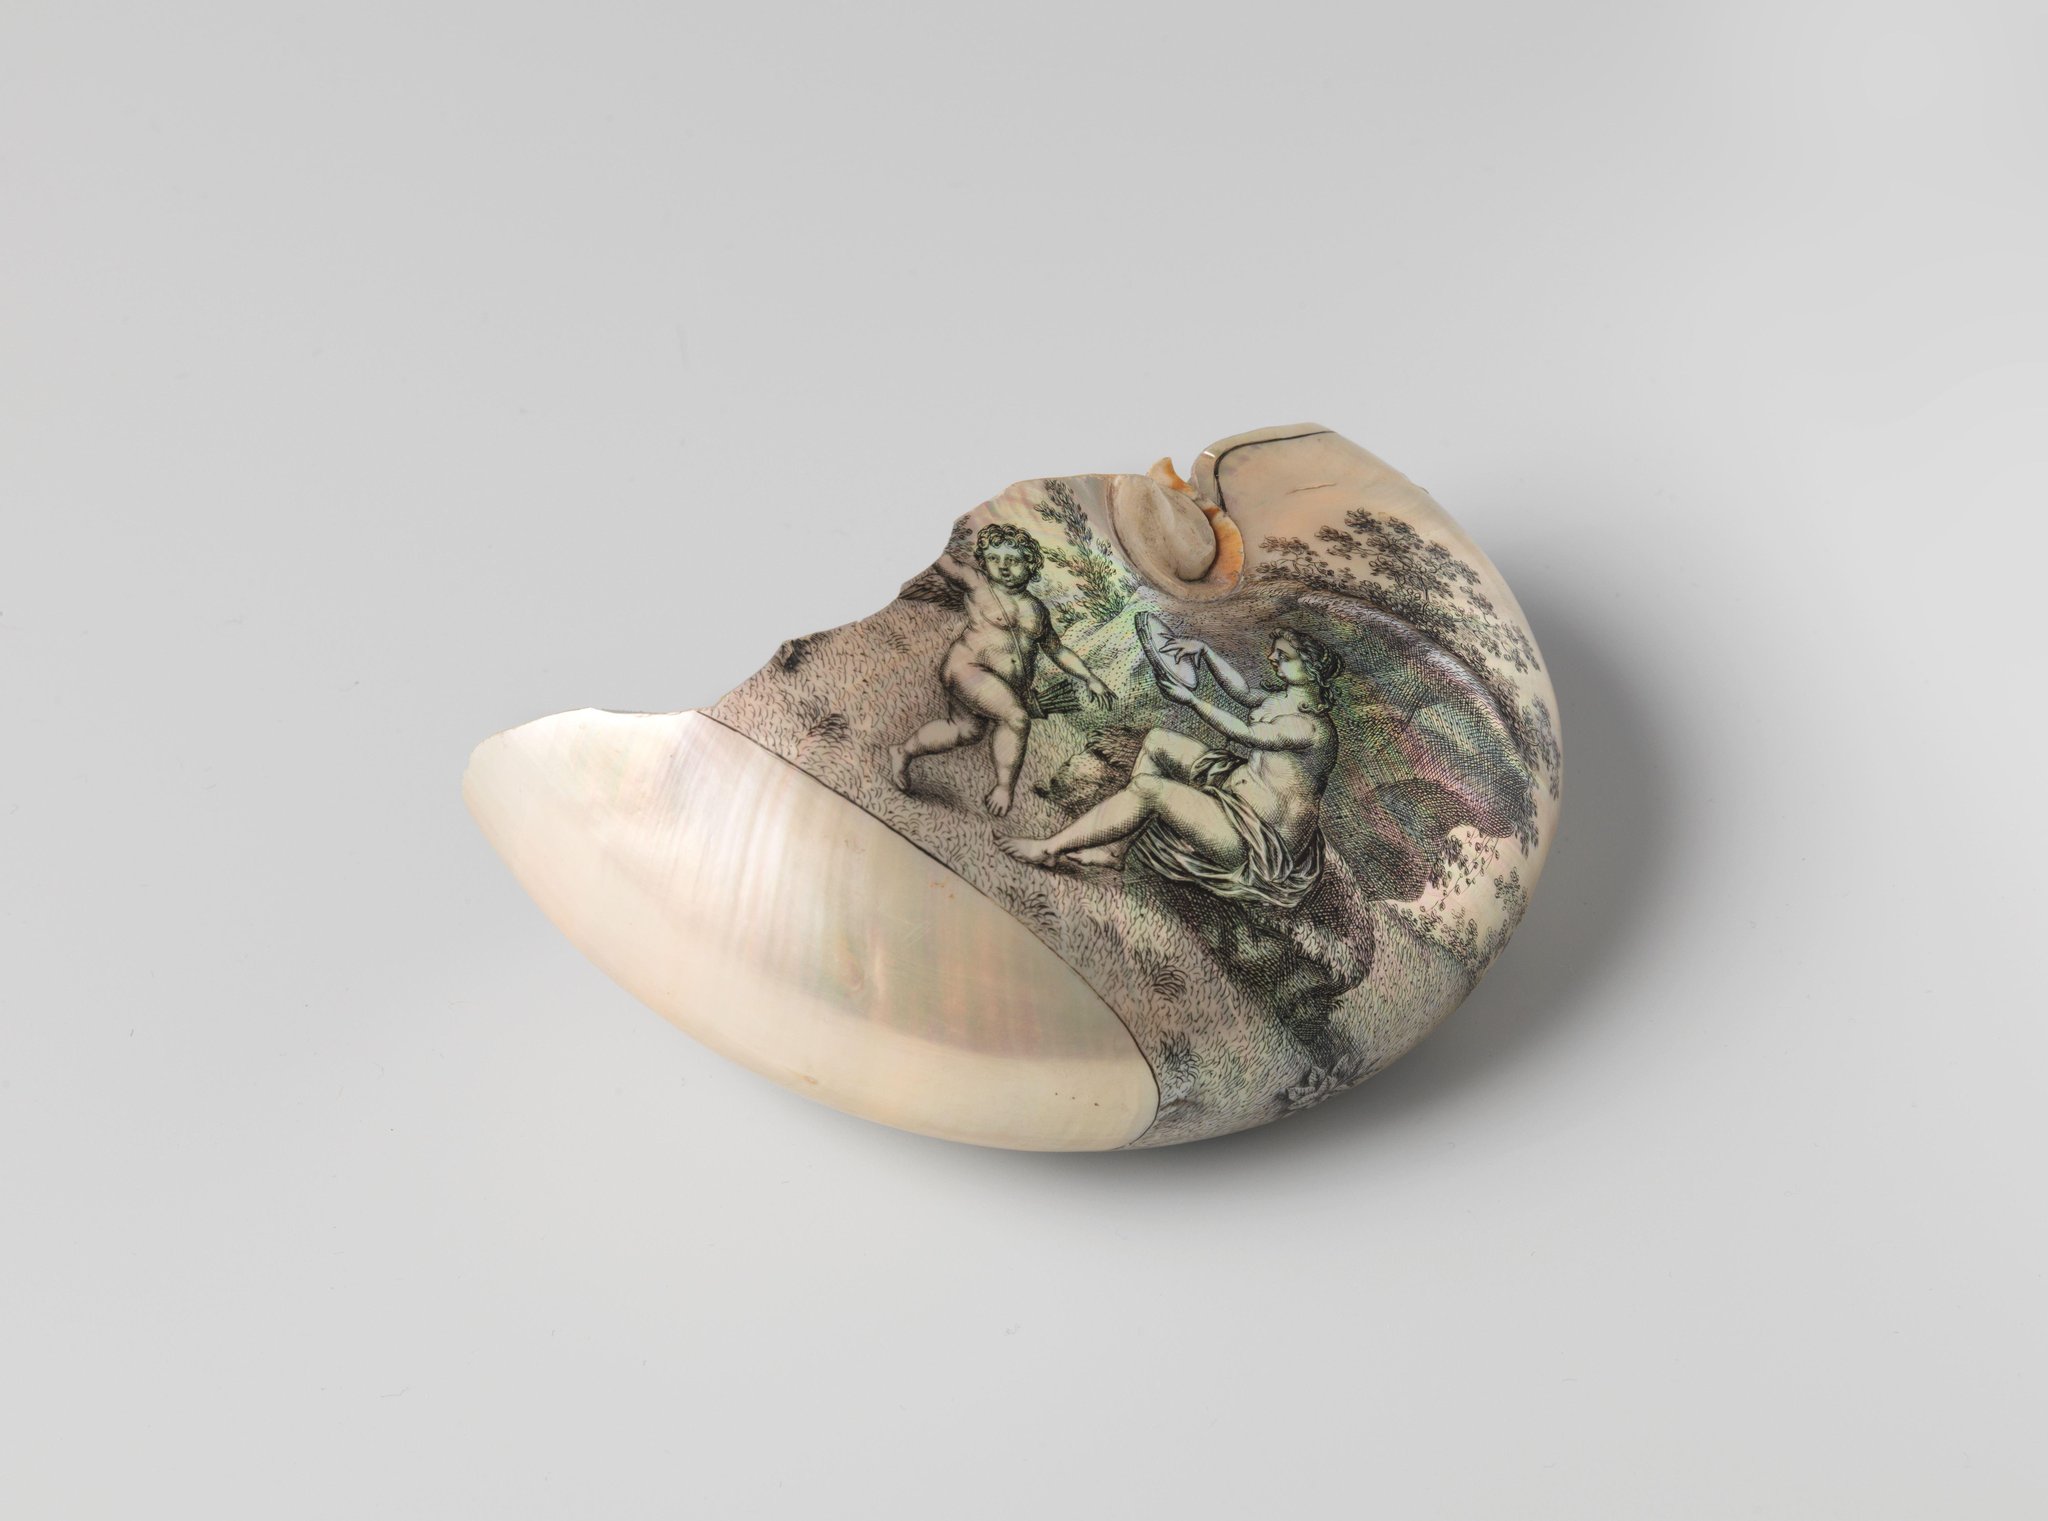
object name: nautilus shell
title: Nautilusschelp, gegraveerd met een dansend Bacchus-kind en met nymph en amor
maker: cornelis bellekin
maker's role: jeweler, painter, print maker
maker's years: 1625-1711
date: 1650-1700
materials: mother of pearl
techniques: engraving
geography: amsterdam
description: Een gegraveerd en zwart ingewreven nautilusschelp. Aan de ene zijde een nymph met een triangel en een dansend Bacchus-kind en aan de andere zijde een nymph met een tambourijn en een dansende Amor.